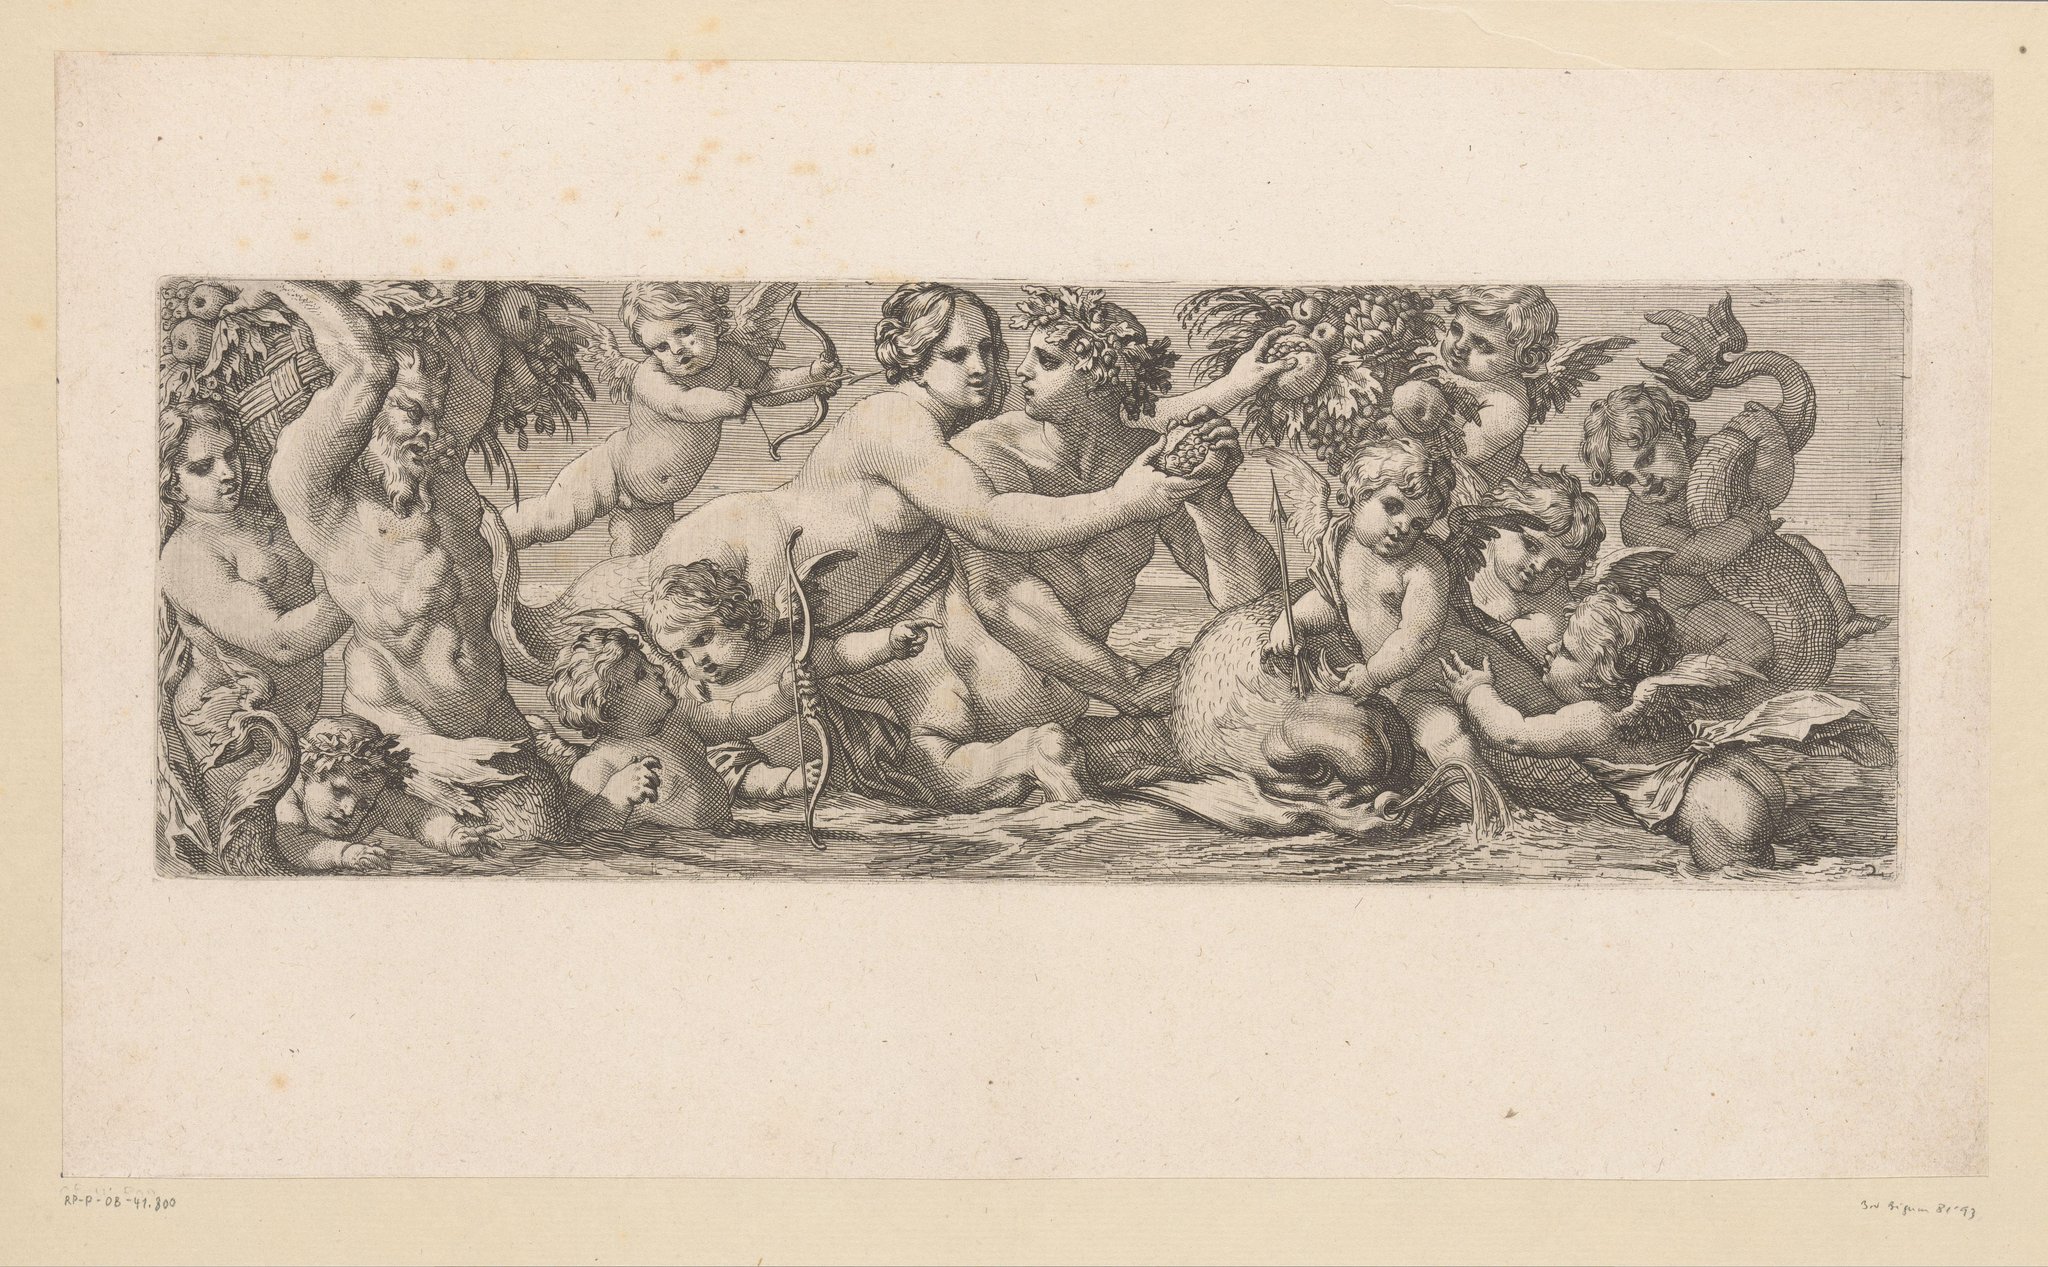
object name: print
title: Mythologische figuren aan het water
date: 1630-1720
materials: paper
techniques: engraving, etching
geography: france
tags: swimming mammals: dolphin, (story of) bacchus (dionysus), liber, nereids, daughters of nereus; sea-nymphs, bunch of grapes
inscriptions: collector's mark: Lugt 240